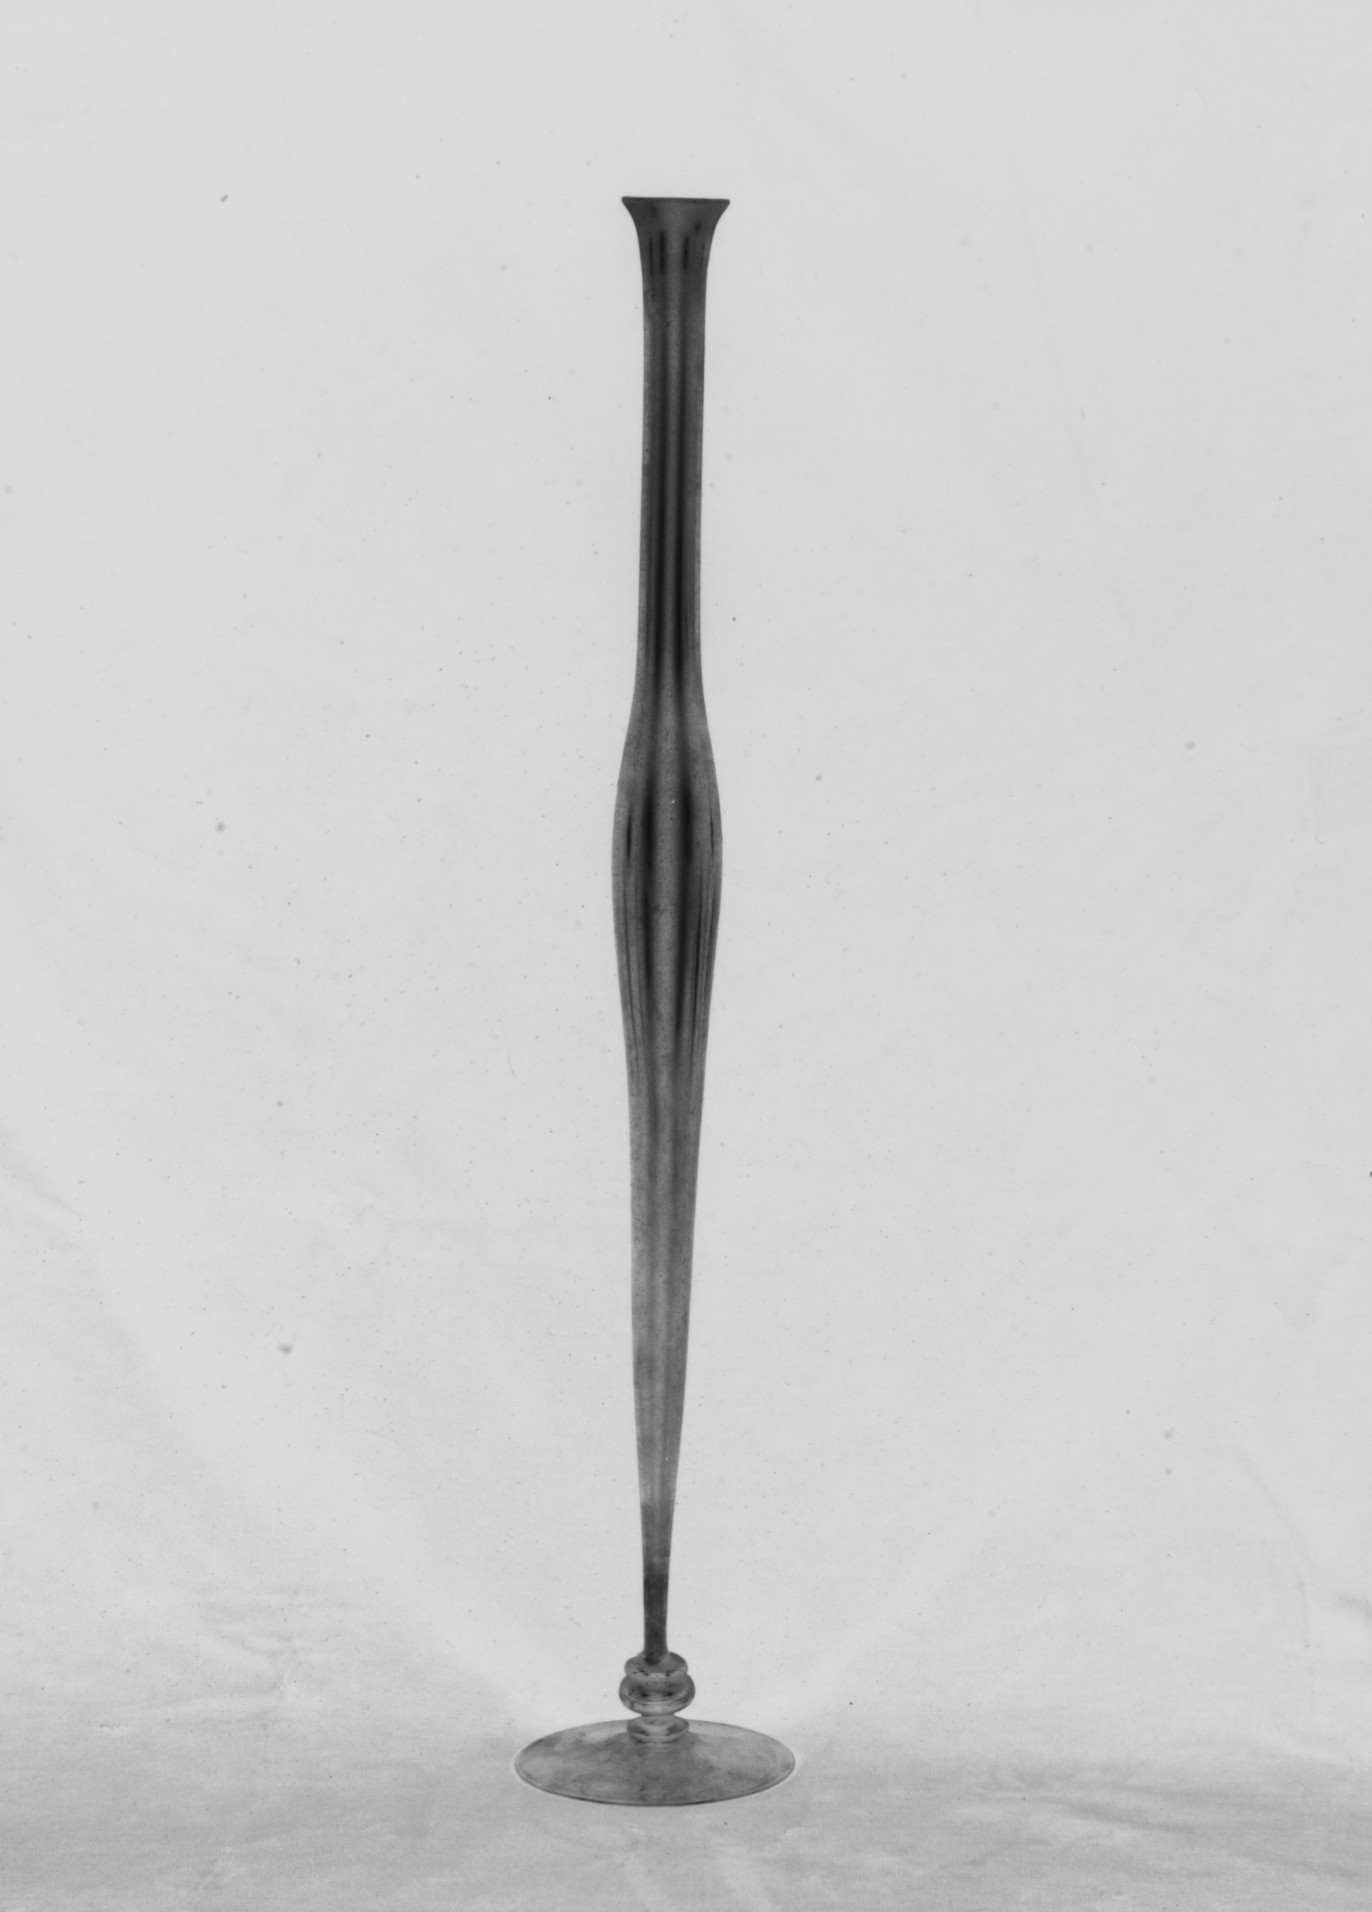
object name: vase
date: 1601-1700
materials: glass